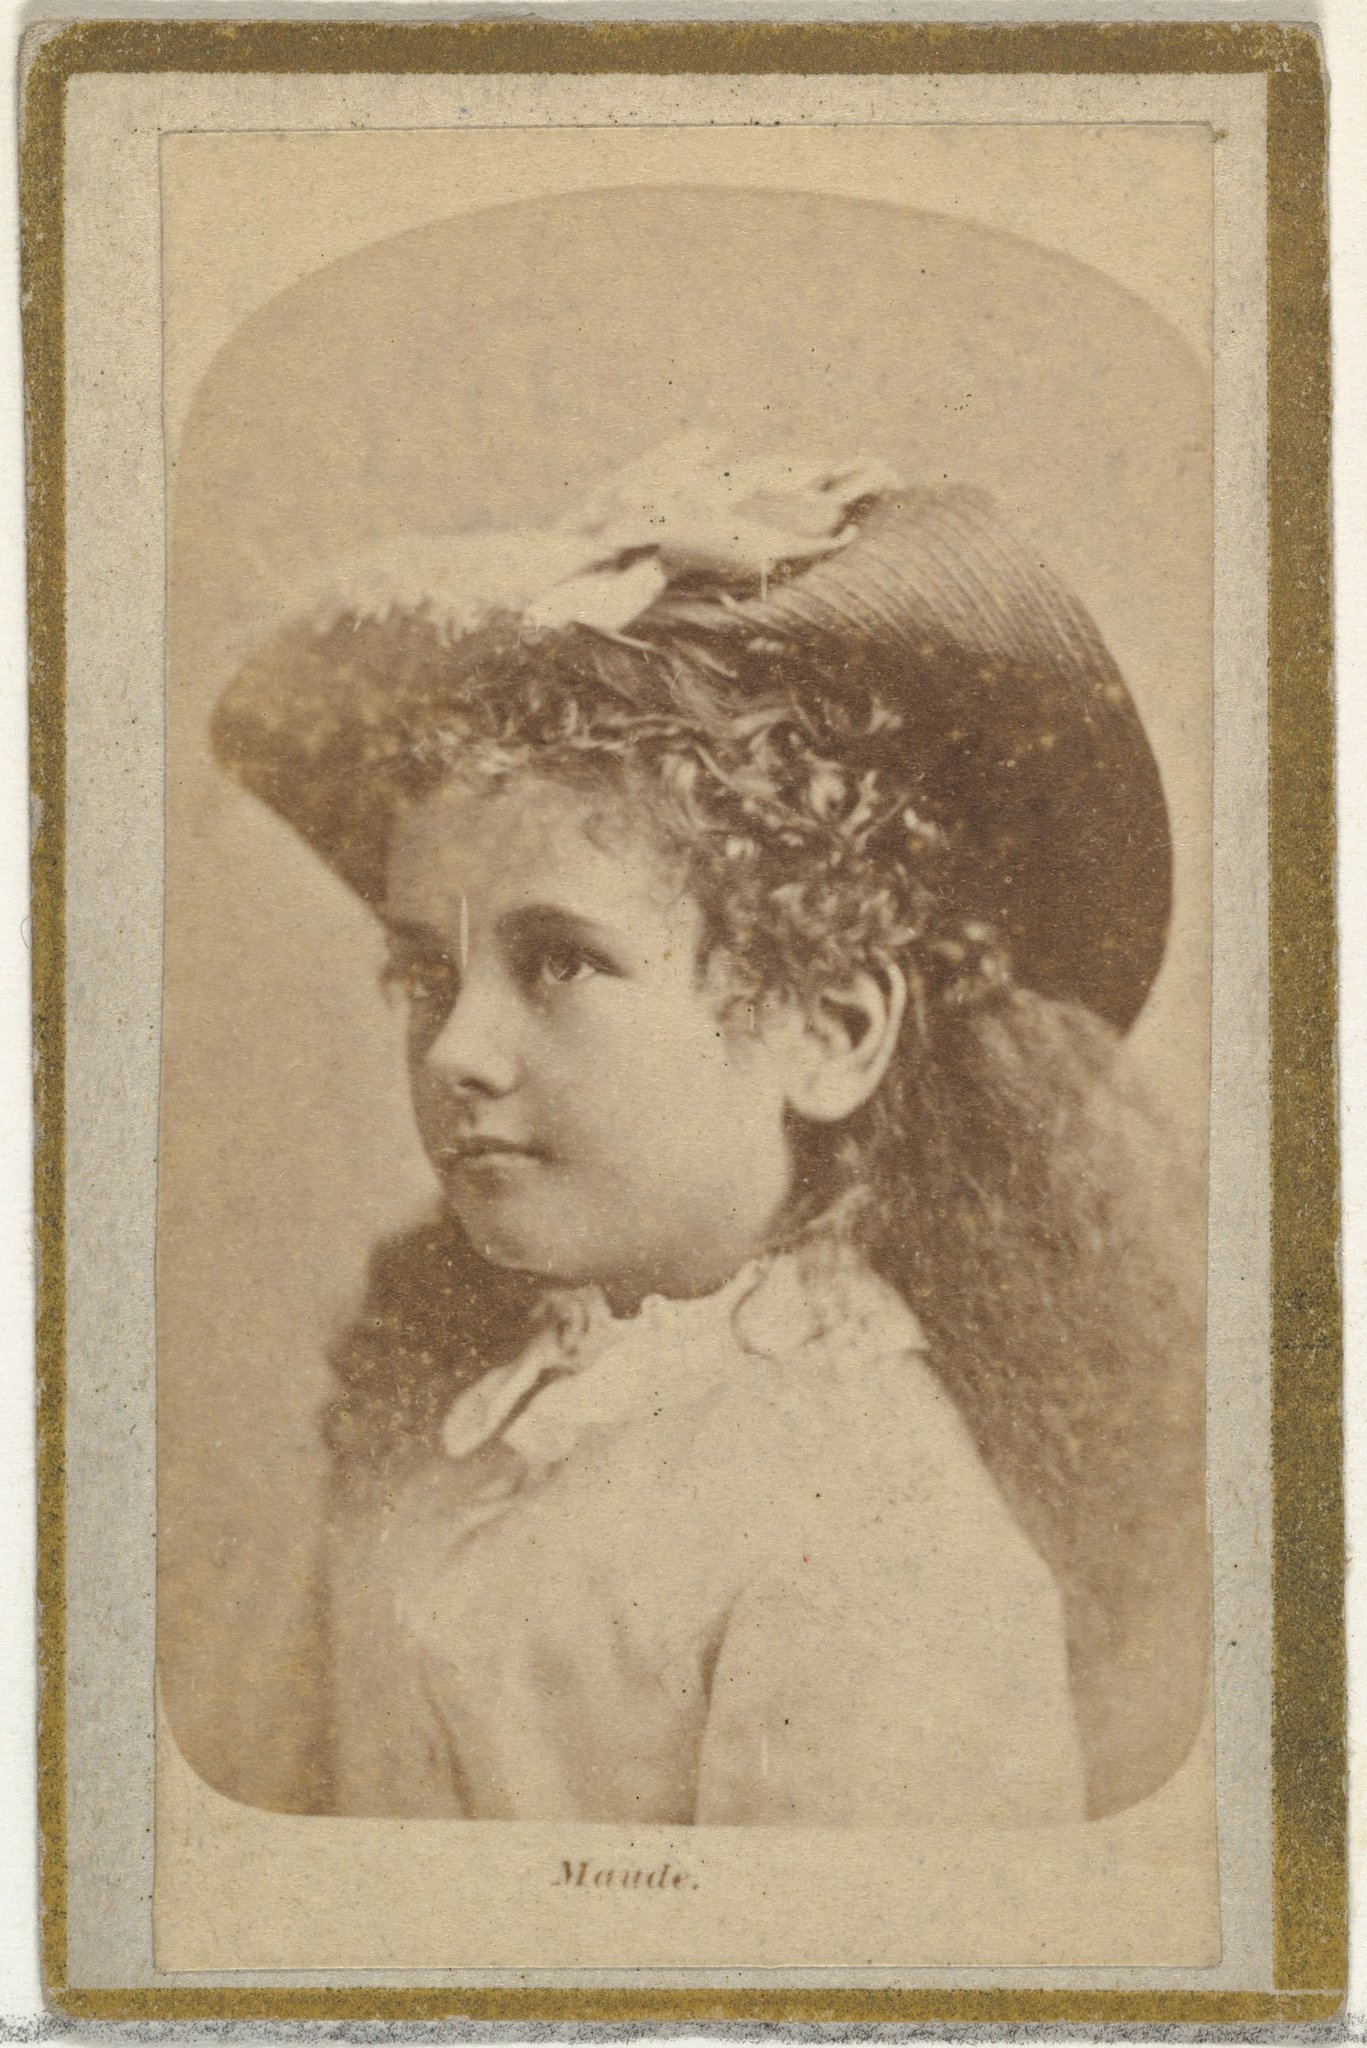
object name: photograph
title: Maude, from the Actresses and Celebrities series (N60, Type 2) promoting Little Beauties Cigarettes for Allen & Ginter brand tobacco products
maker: allen & ginter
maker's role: publisher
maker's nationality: american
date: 1887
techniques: albumen silver print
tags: girls,portraits,actresses